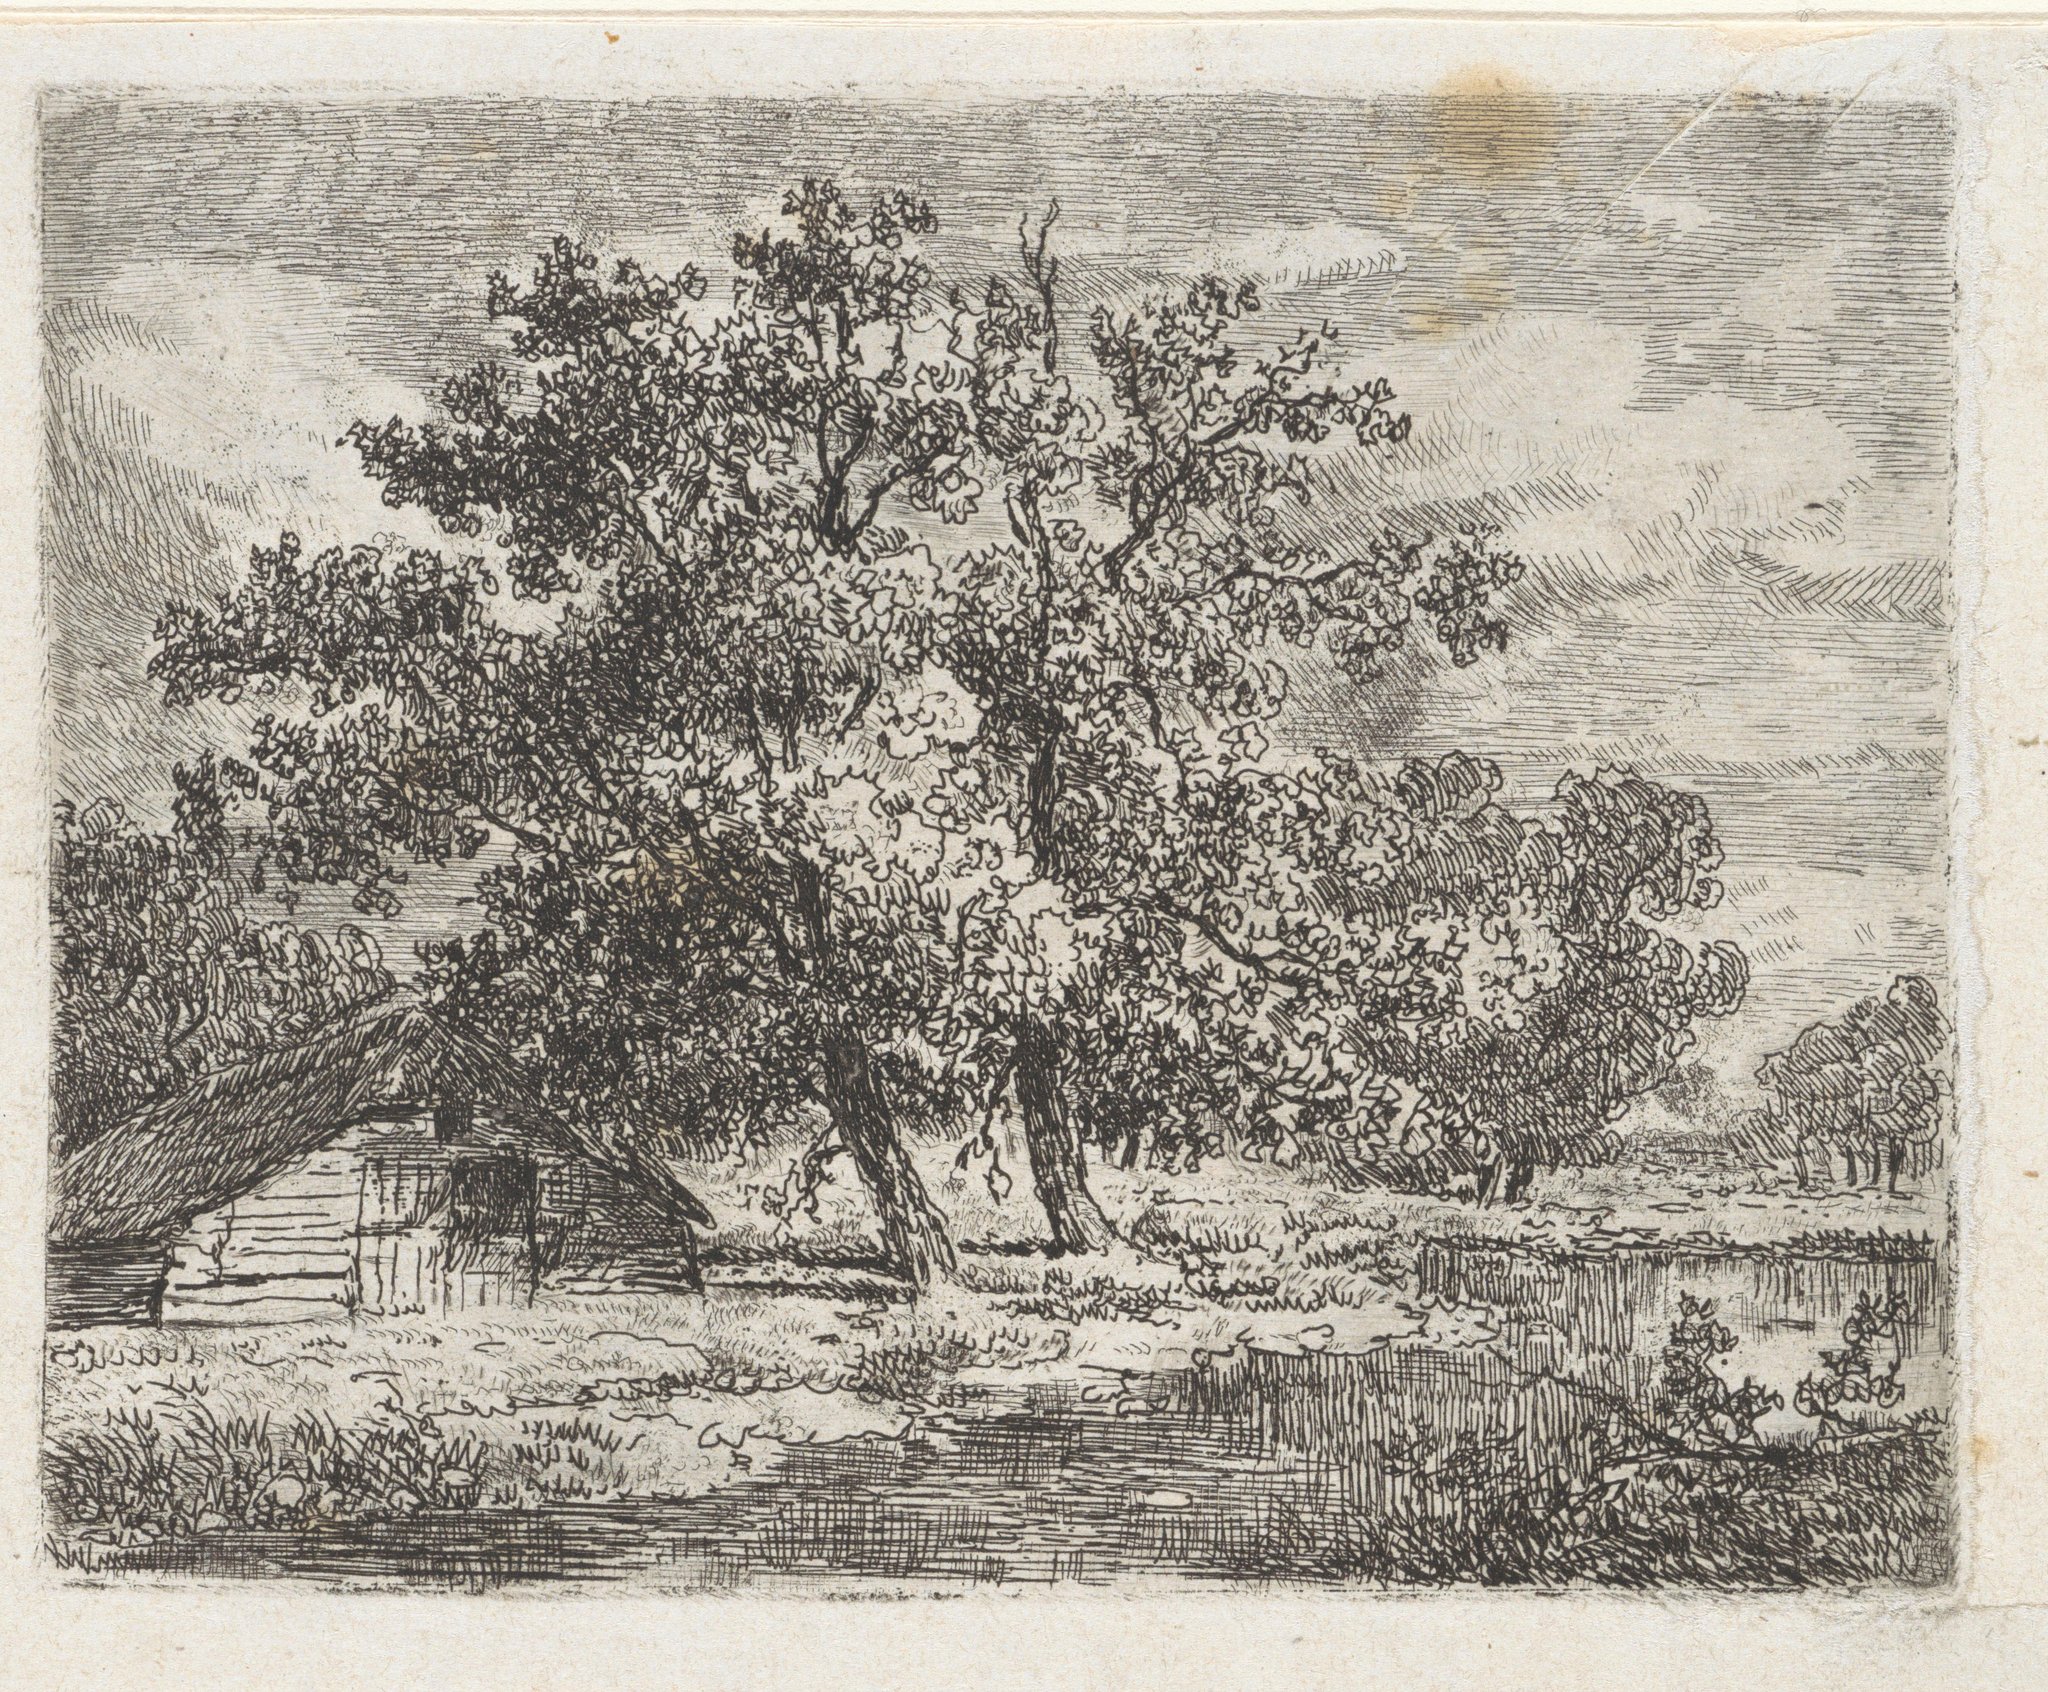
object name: print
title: Houten hut onder twee bomen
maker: johannes pieter van wisselingh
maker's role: draughtsman, painter, print maker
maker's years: 1812-1899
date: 1830-1878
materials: paper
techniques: etching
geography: netherlands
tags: trees, brook, hut, cabin, lodge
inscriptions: collector's mark: Lugt 1485, collector's mark: Lugt 2228, name: ‘Wesseling’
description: Links staat een houten hut onder twee bomen. Rechts stroomt een beek.